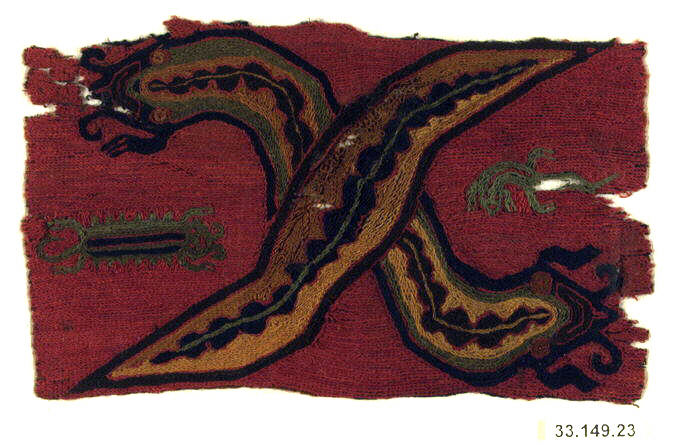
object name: border fragment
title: Embroidered Border Fragment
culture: paracas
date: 400-201 BCE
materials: animal fiber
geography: peru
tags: serpents